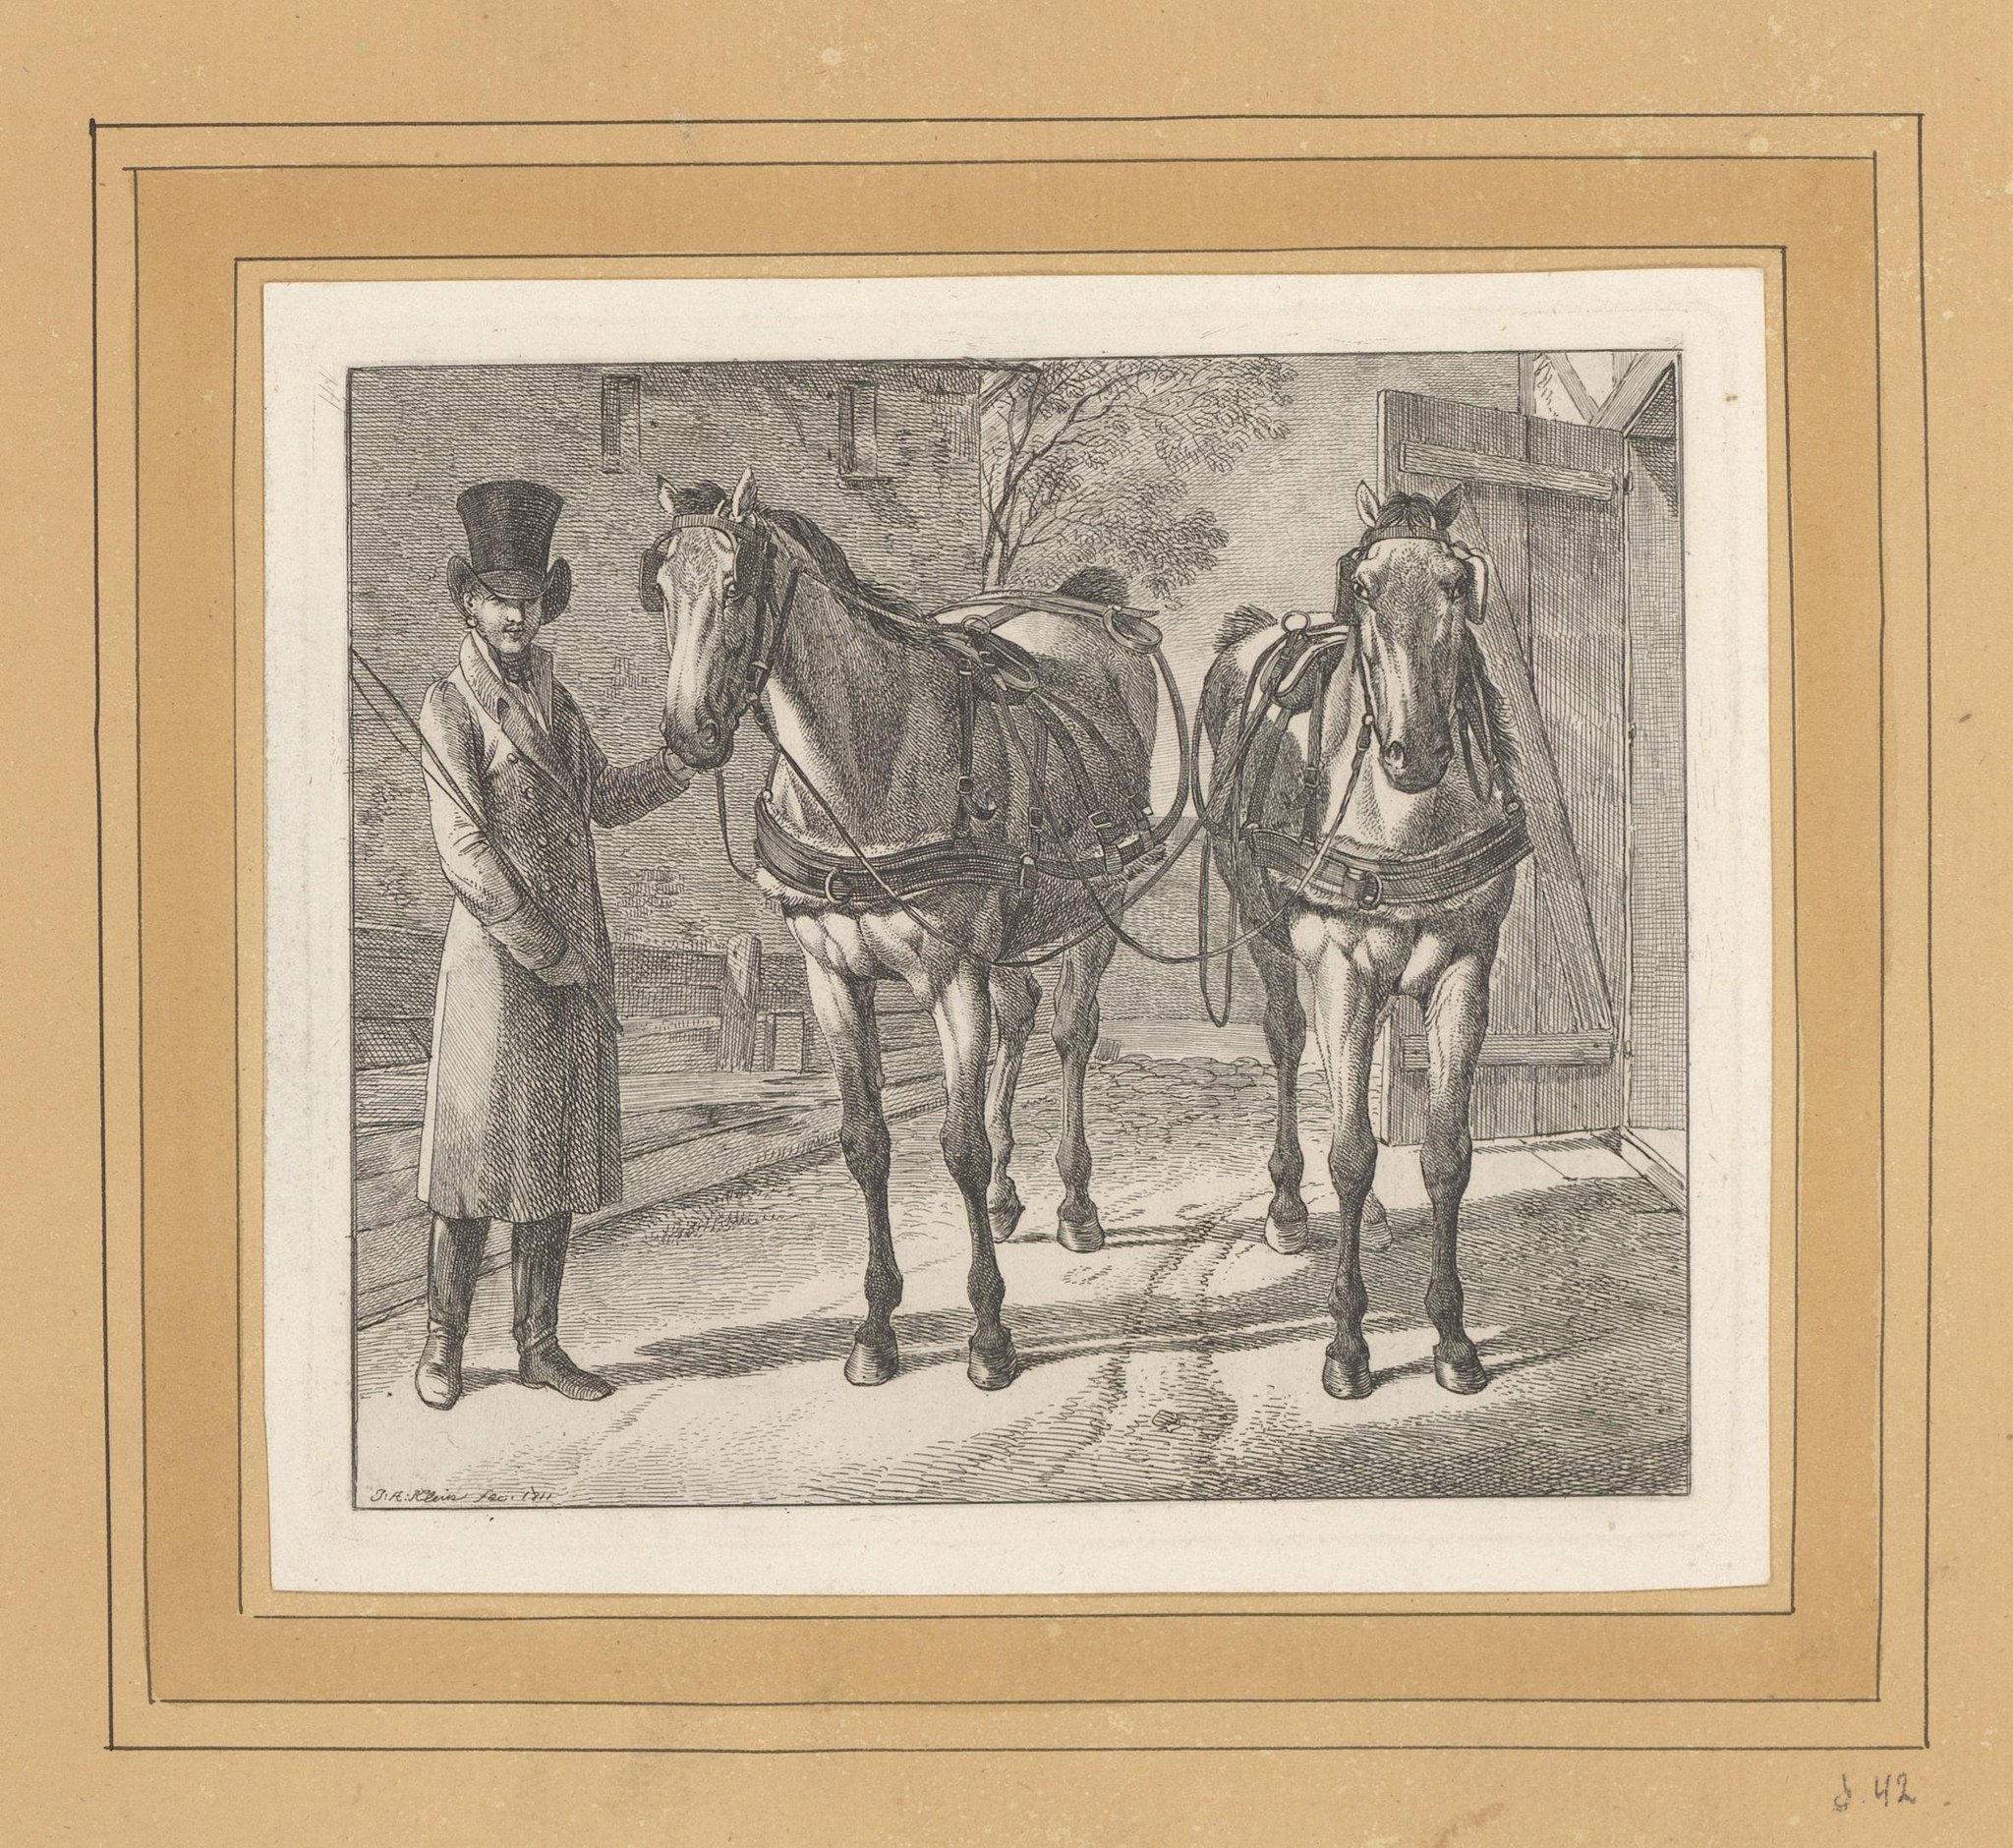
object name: print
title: Koetsier met twee trekpaarden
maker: johann adam klein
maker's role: draughtsman, print maker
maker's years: 1792-1875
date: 1811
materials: paper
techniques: etching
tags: hitching up, harnessing ~ animal traction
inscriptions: collector's mark: Lugt 2228, collector's mark: Lugt 2760